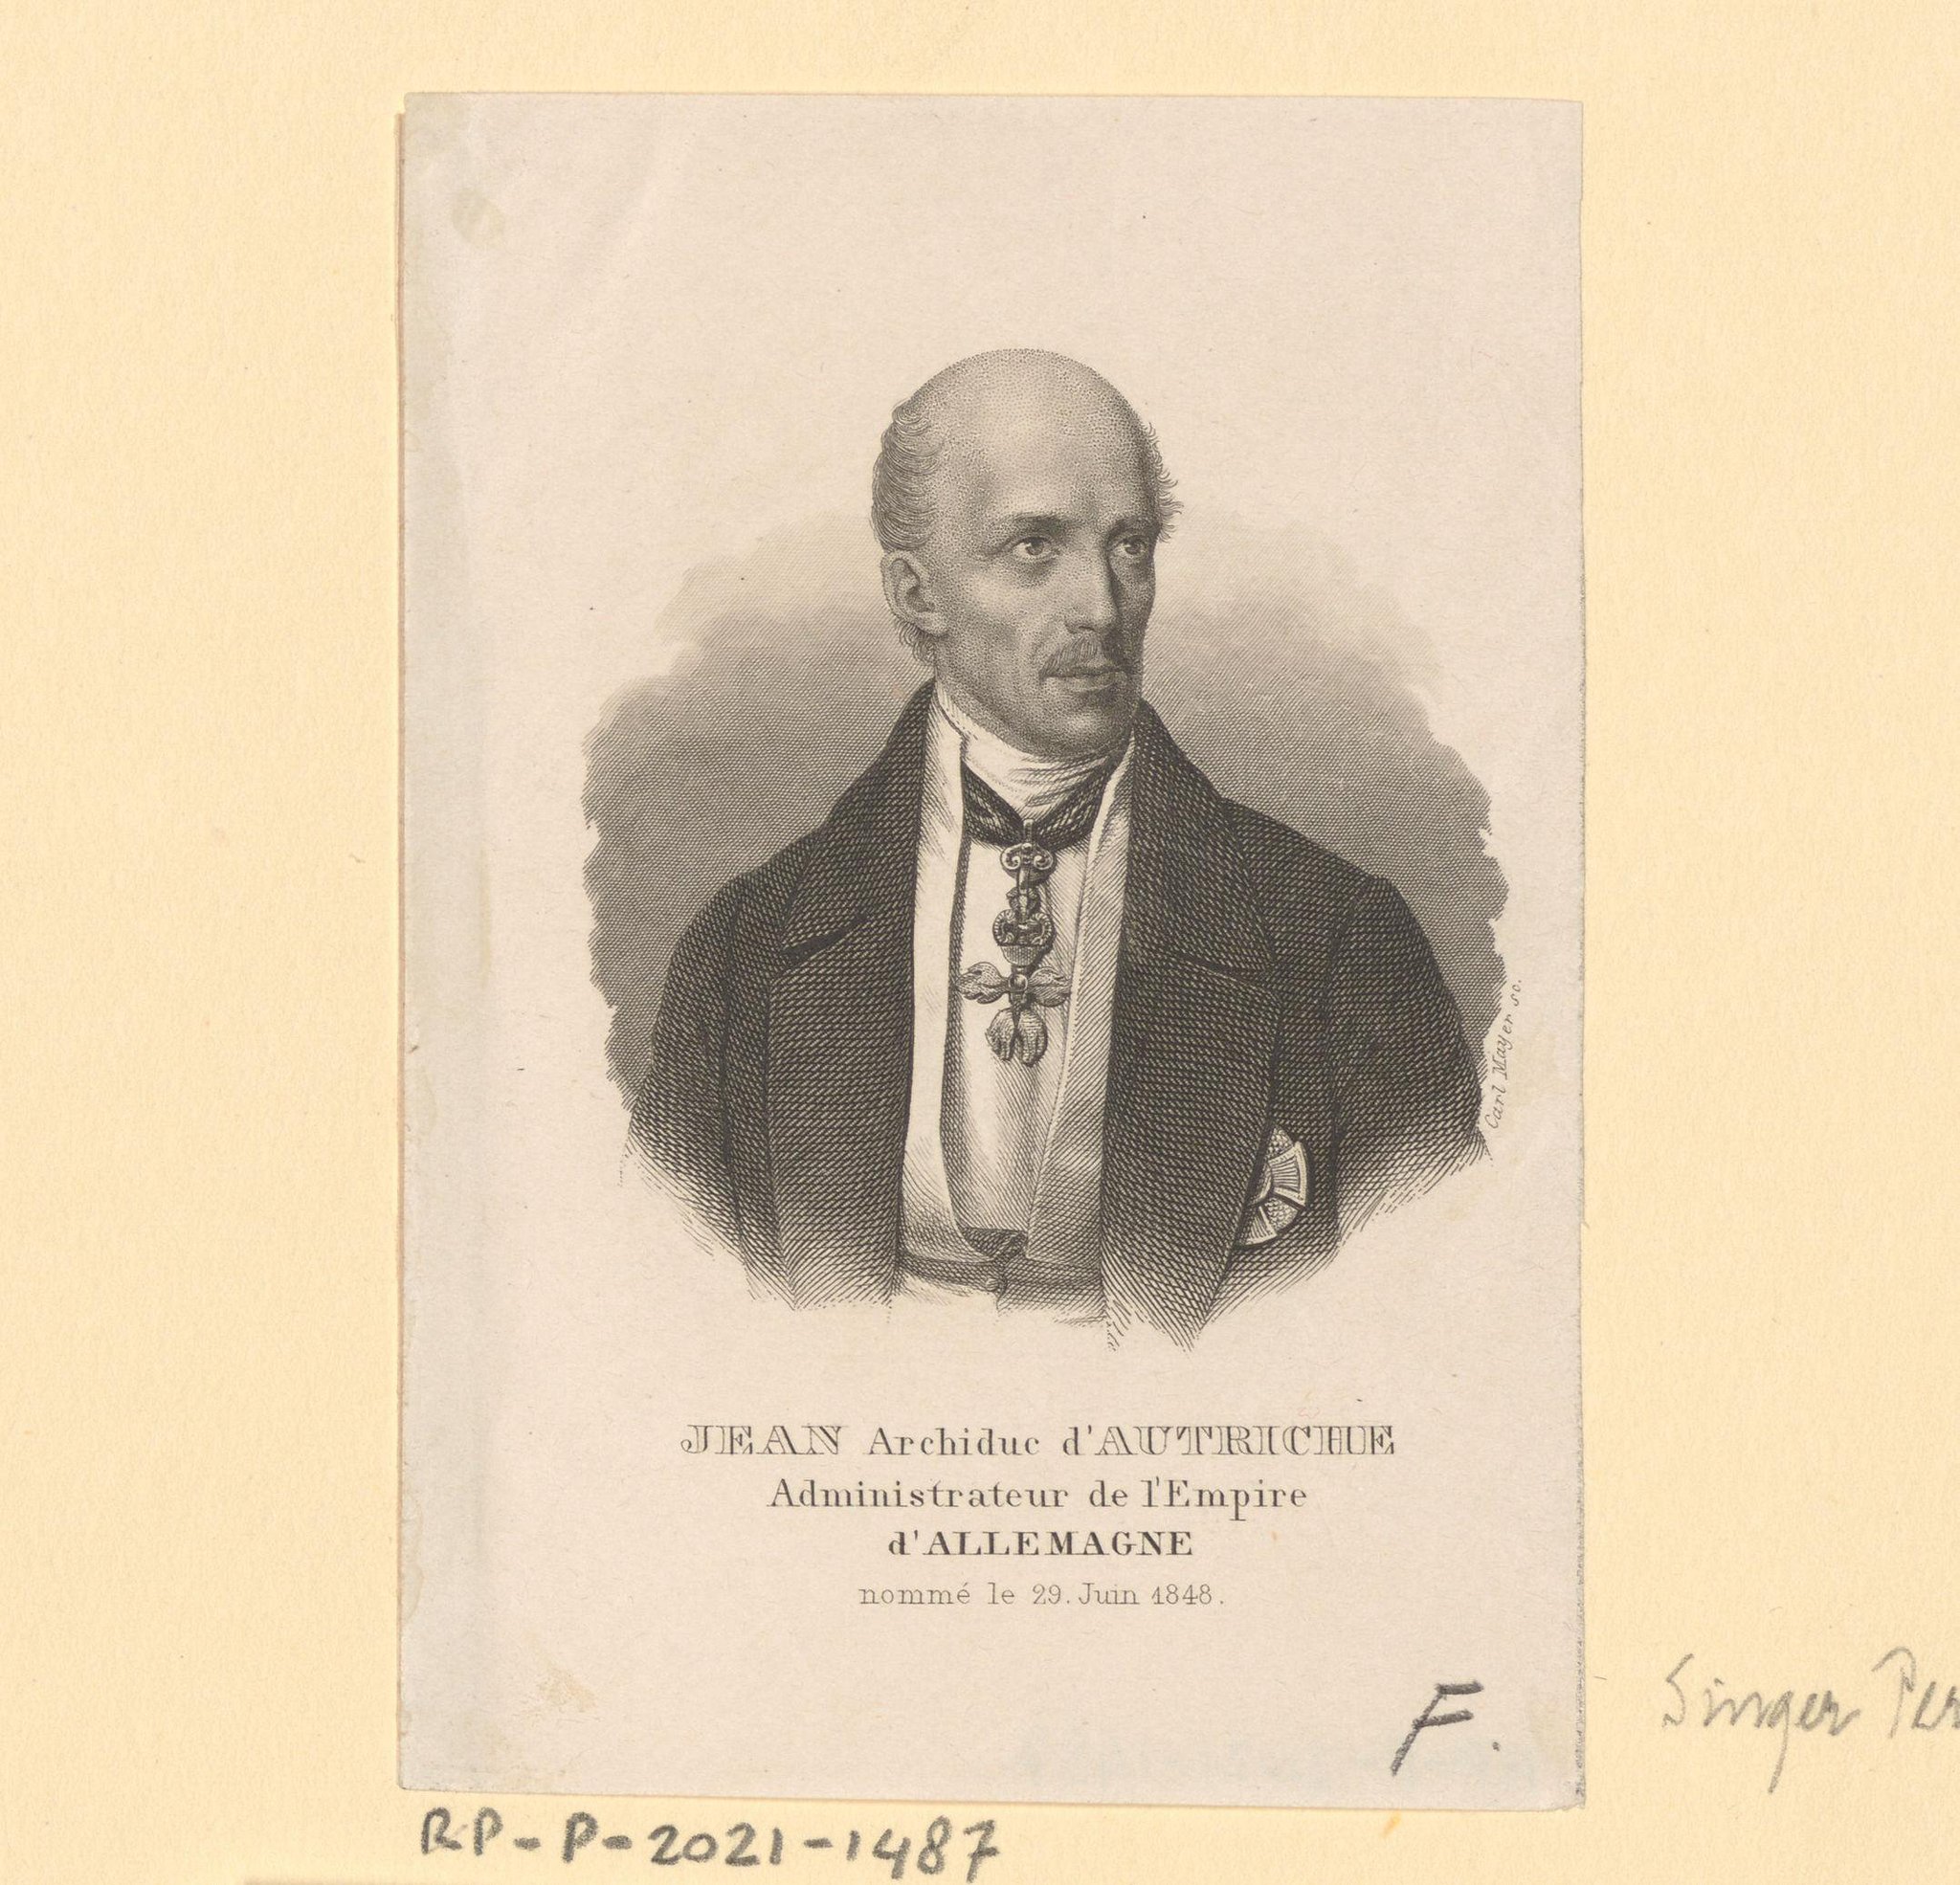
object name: print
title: Portret van Johan van Oostenrijk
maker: carl mayer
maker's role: print maker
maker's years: 1798-1868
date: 1848-1868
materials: paper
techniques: engraving, etching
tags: commander-in-chief, general, marshal, historical persons